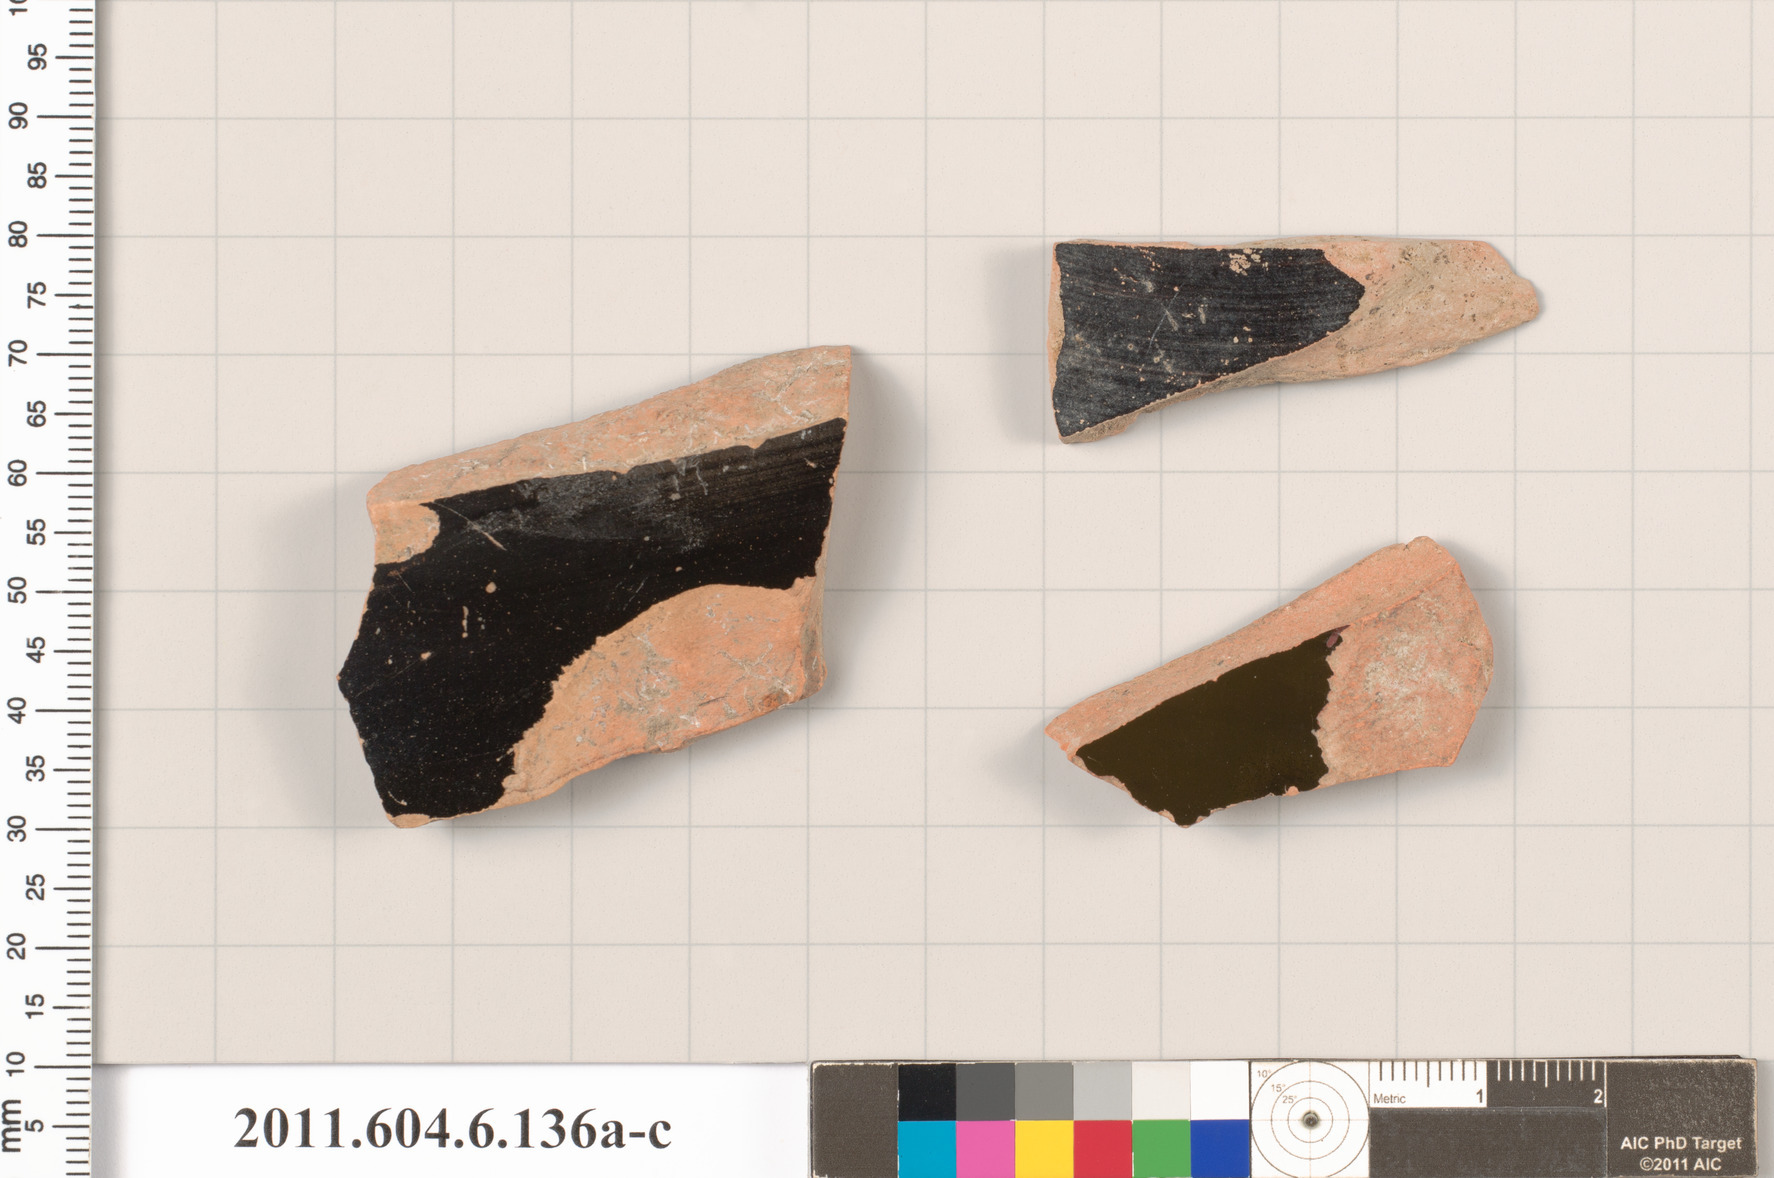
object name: undetermined open shape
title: Terracotta fragments of open shapes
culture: greek, attic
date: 600-401 BCE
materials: terracotta